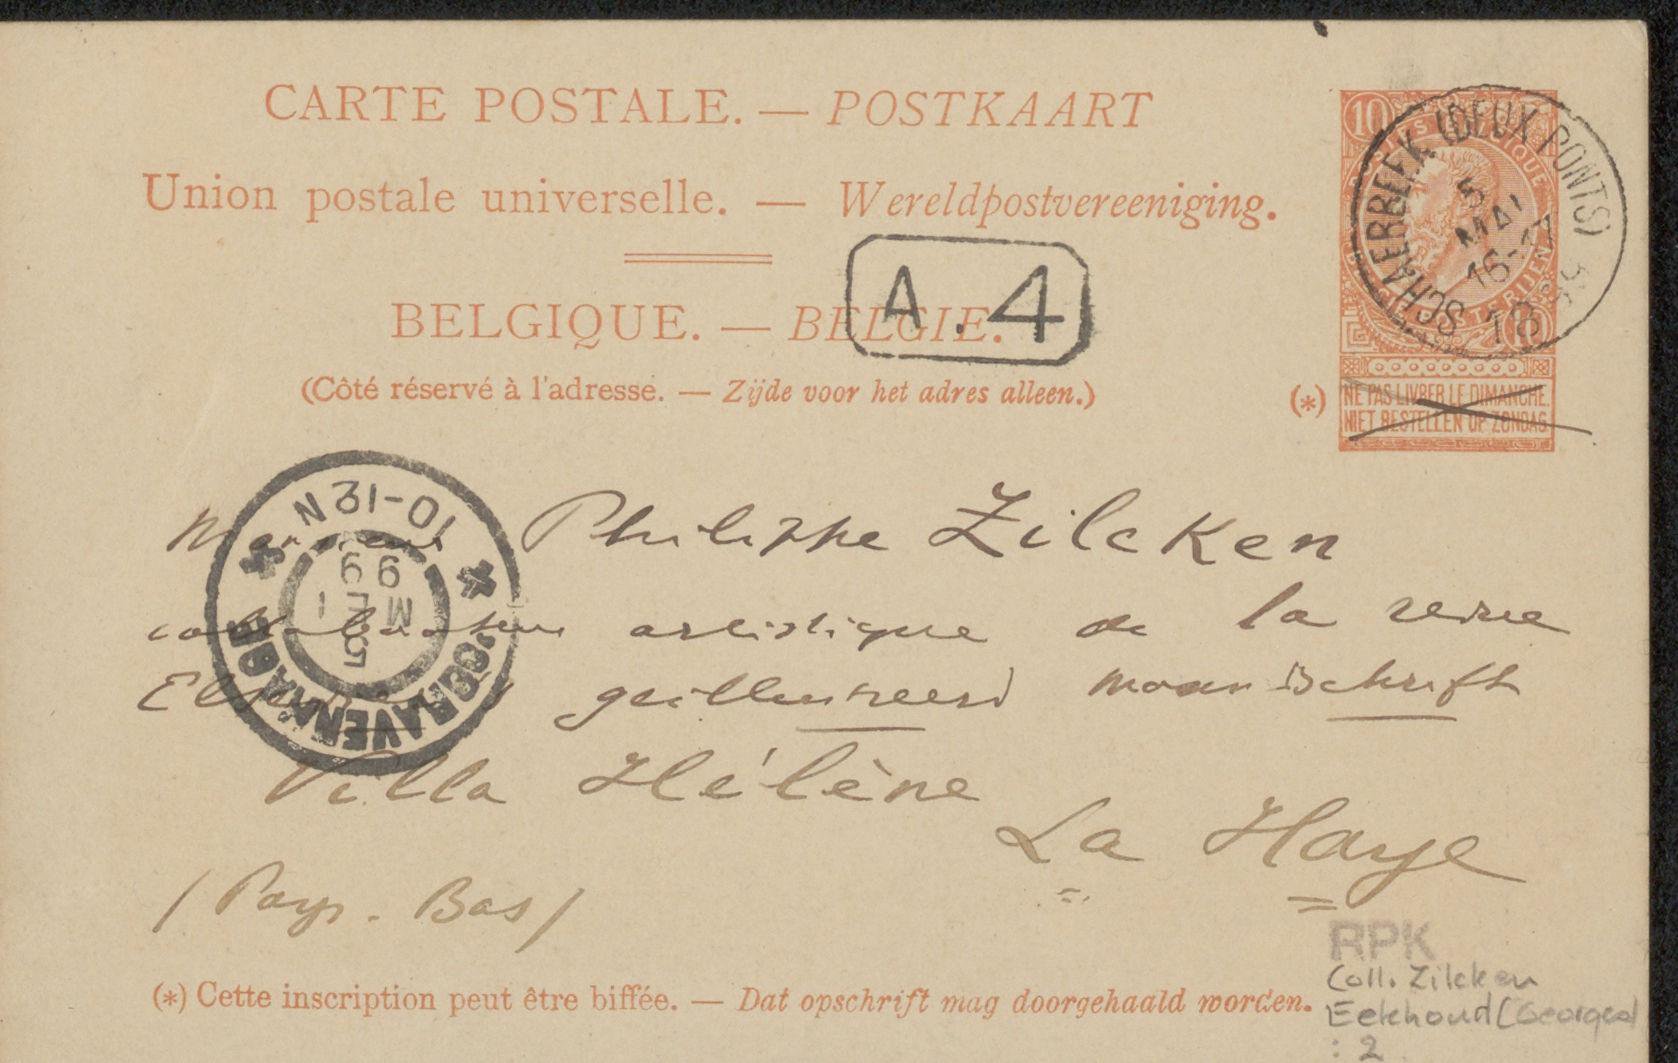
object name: postcard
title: Briefkaart aan Philip Zilcken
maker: georges eekhoud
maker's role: schrijver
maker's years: 1854-1927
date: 1899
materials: cardboard, ink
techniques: pen, writing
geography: brussels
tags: hippolyte emmanuel boulenger, print maker, draughtsman, henri de braekeleer, brussels, painter, charles de groux, joseph stevens, philip zilcken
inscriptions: collector's mark: ‘RPK’